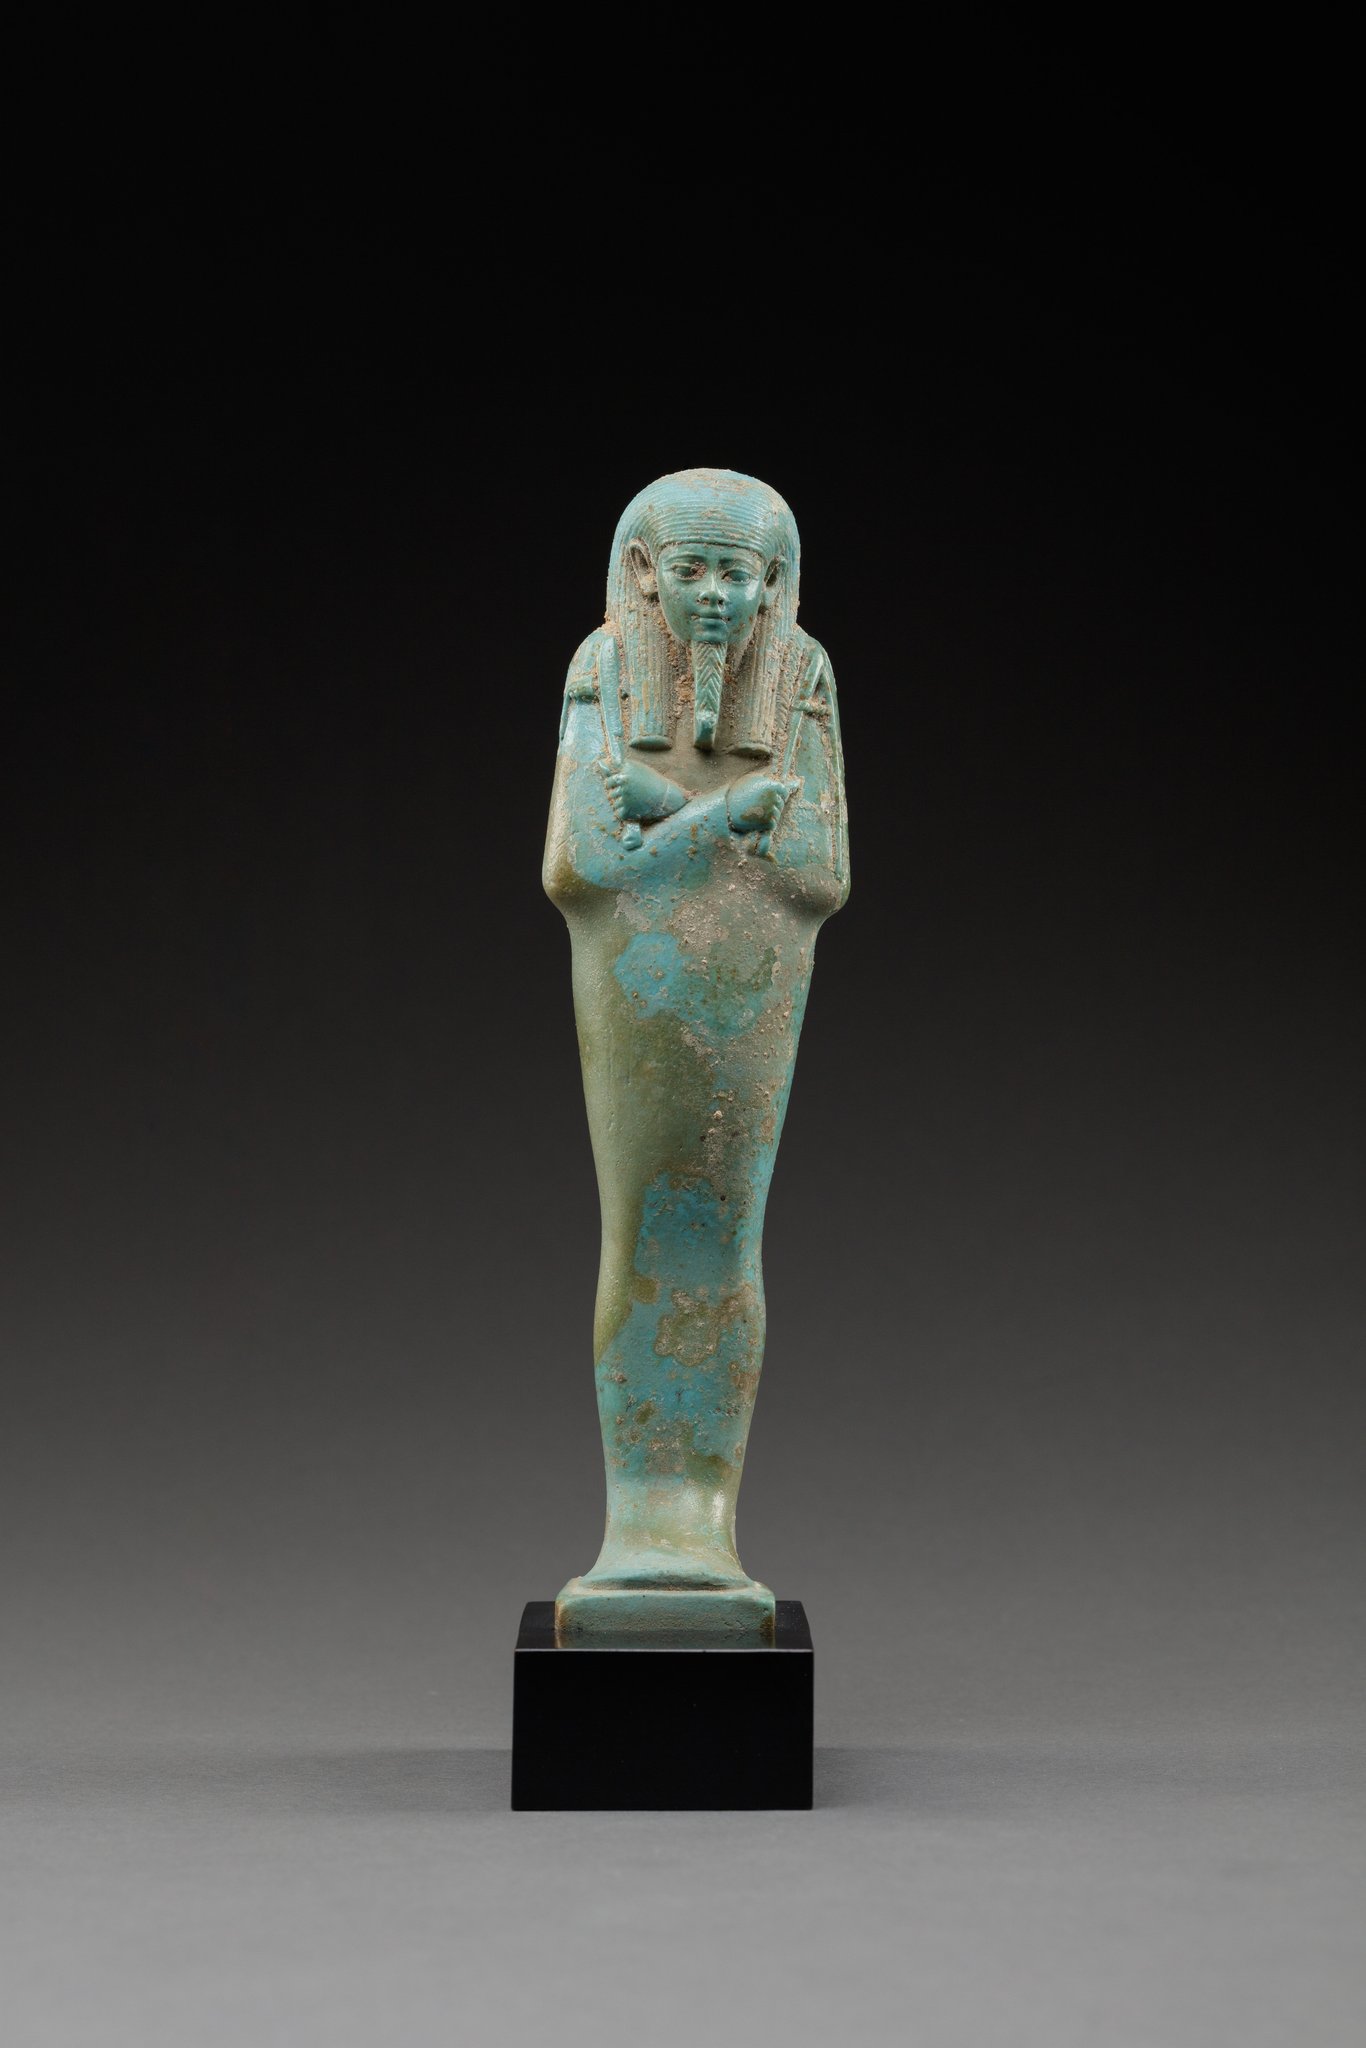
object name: shabti ushabti of the overseer of the fleet, hekaemsaf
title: Shabti of the Overseer of the Fleet Hekaemsaf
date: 570-526 BCE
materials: faience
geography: egypt